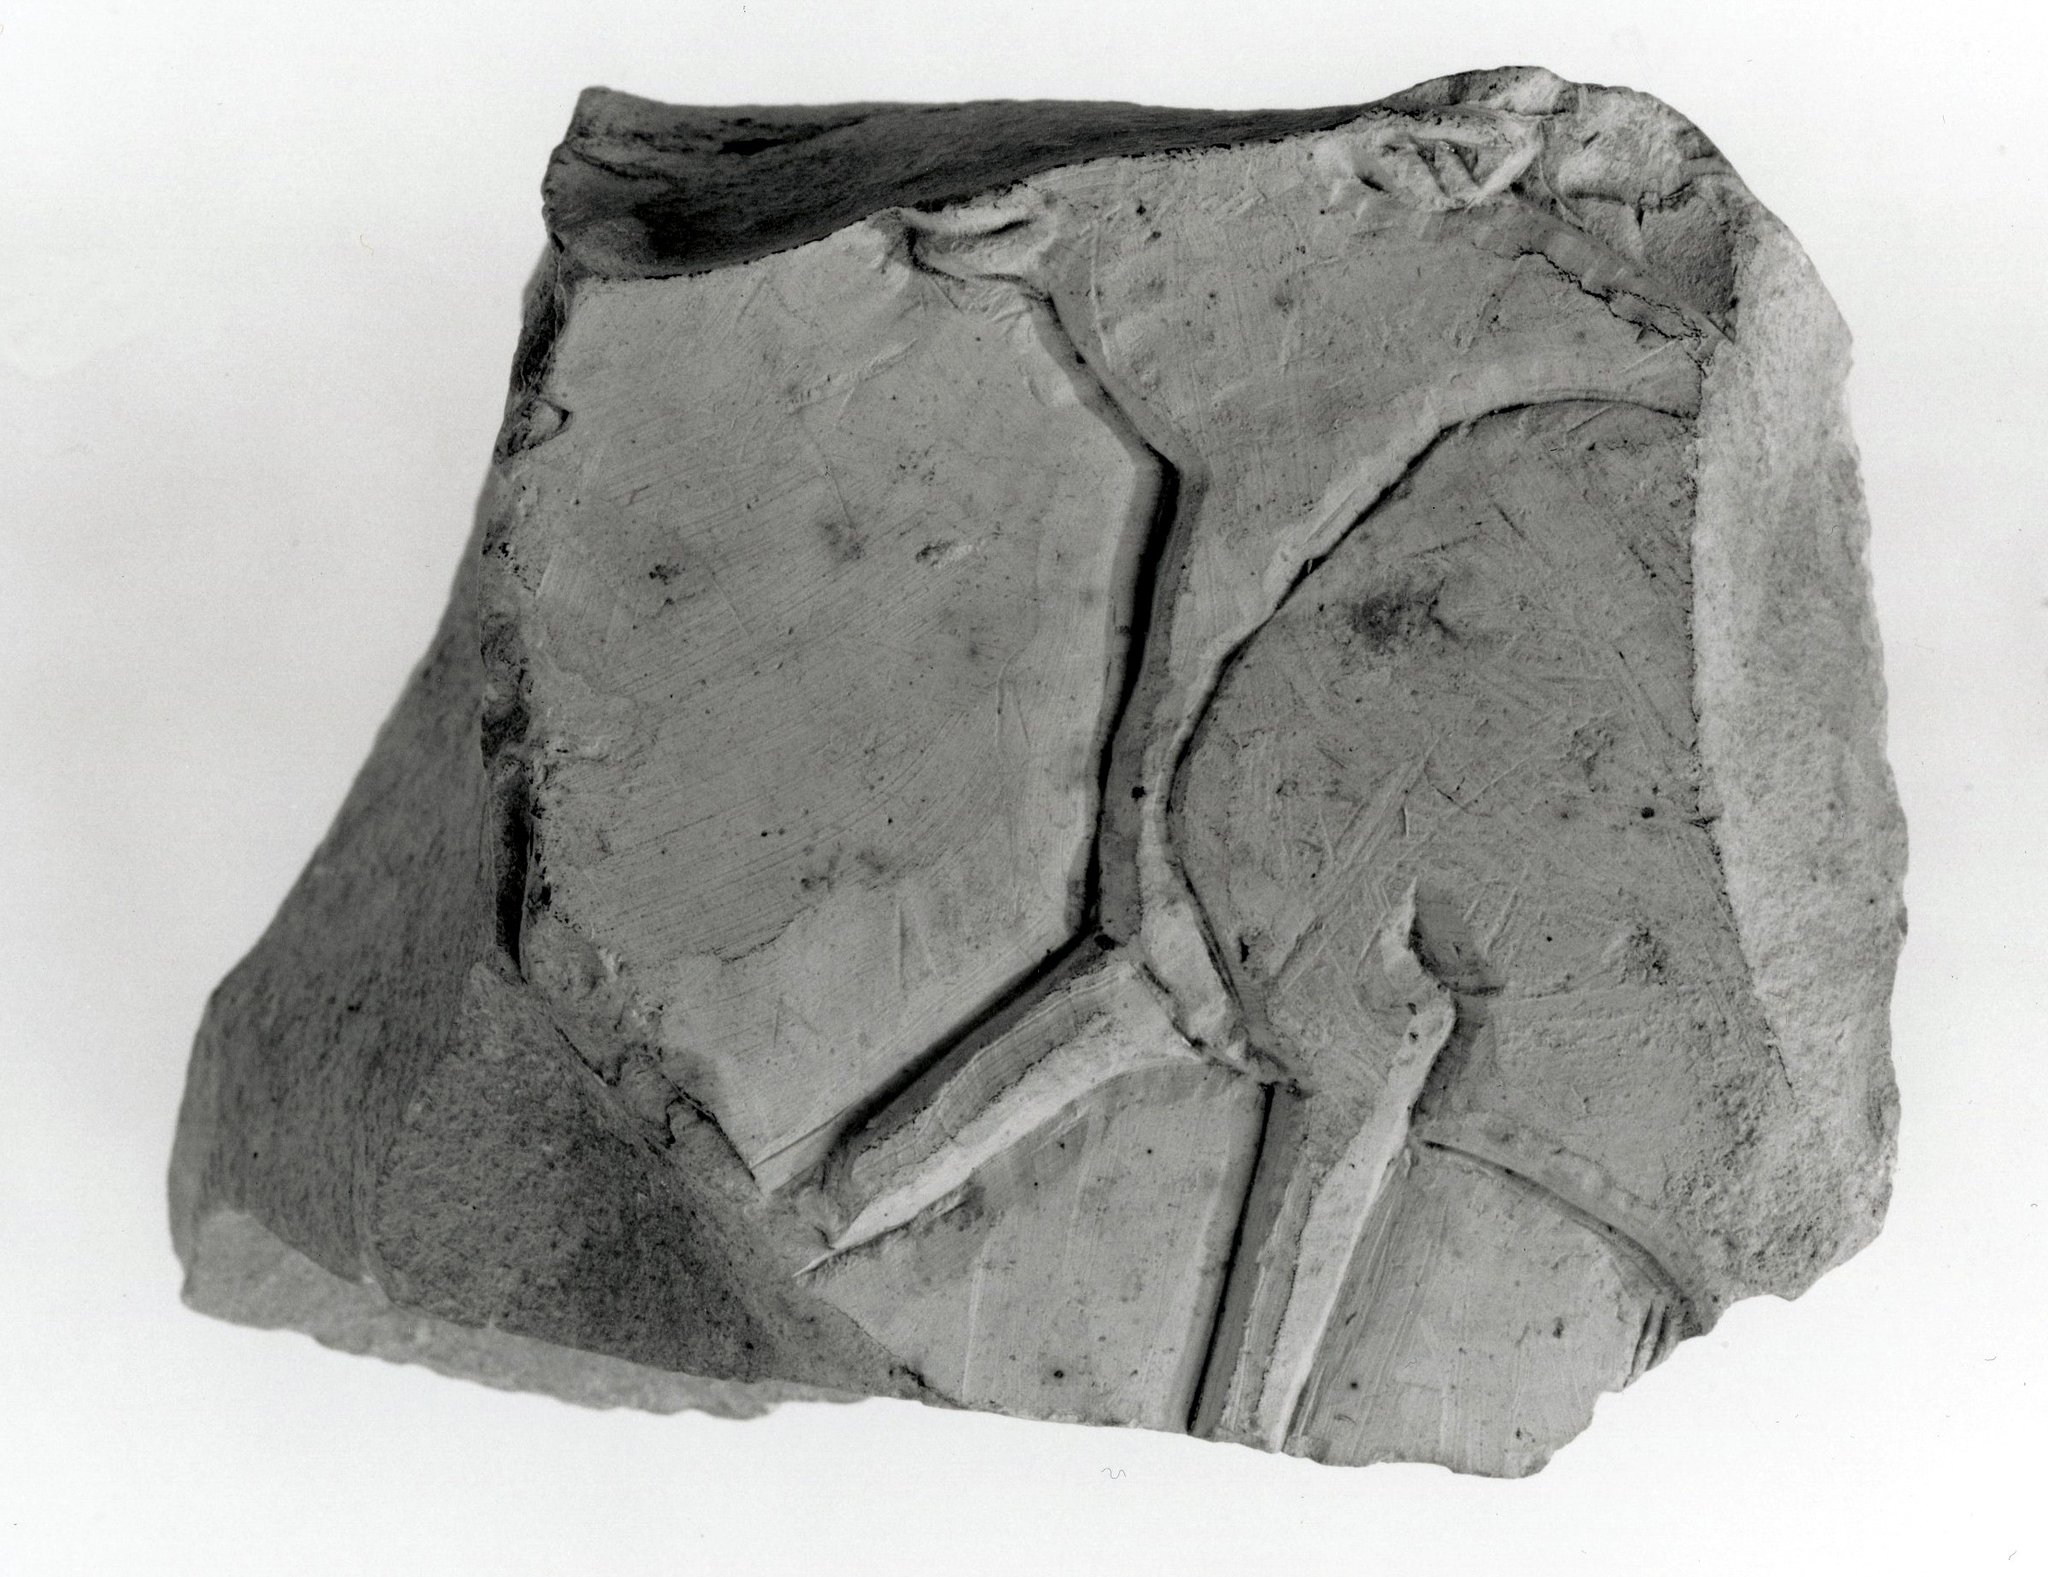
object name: relief, tomb of nespekashuty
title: Raised relief fragment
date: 664-610 BCE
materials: limestone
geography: egypt